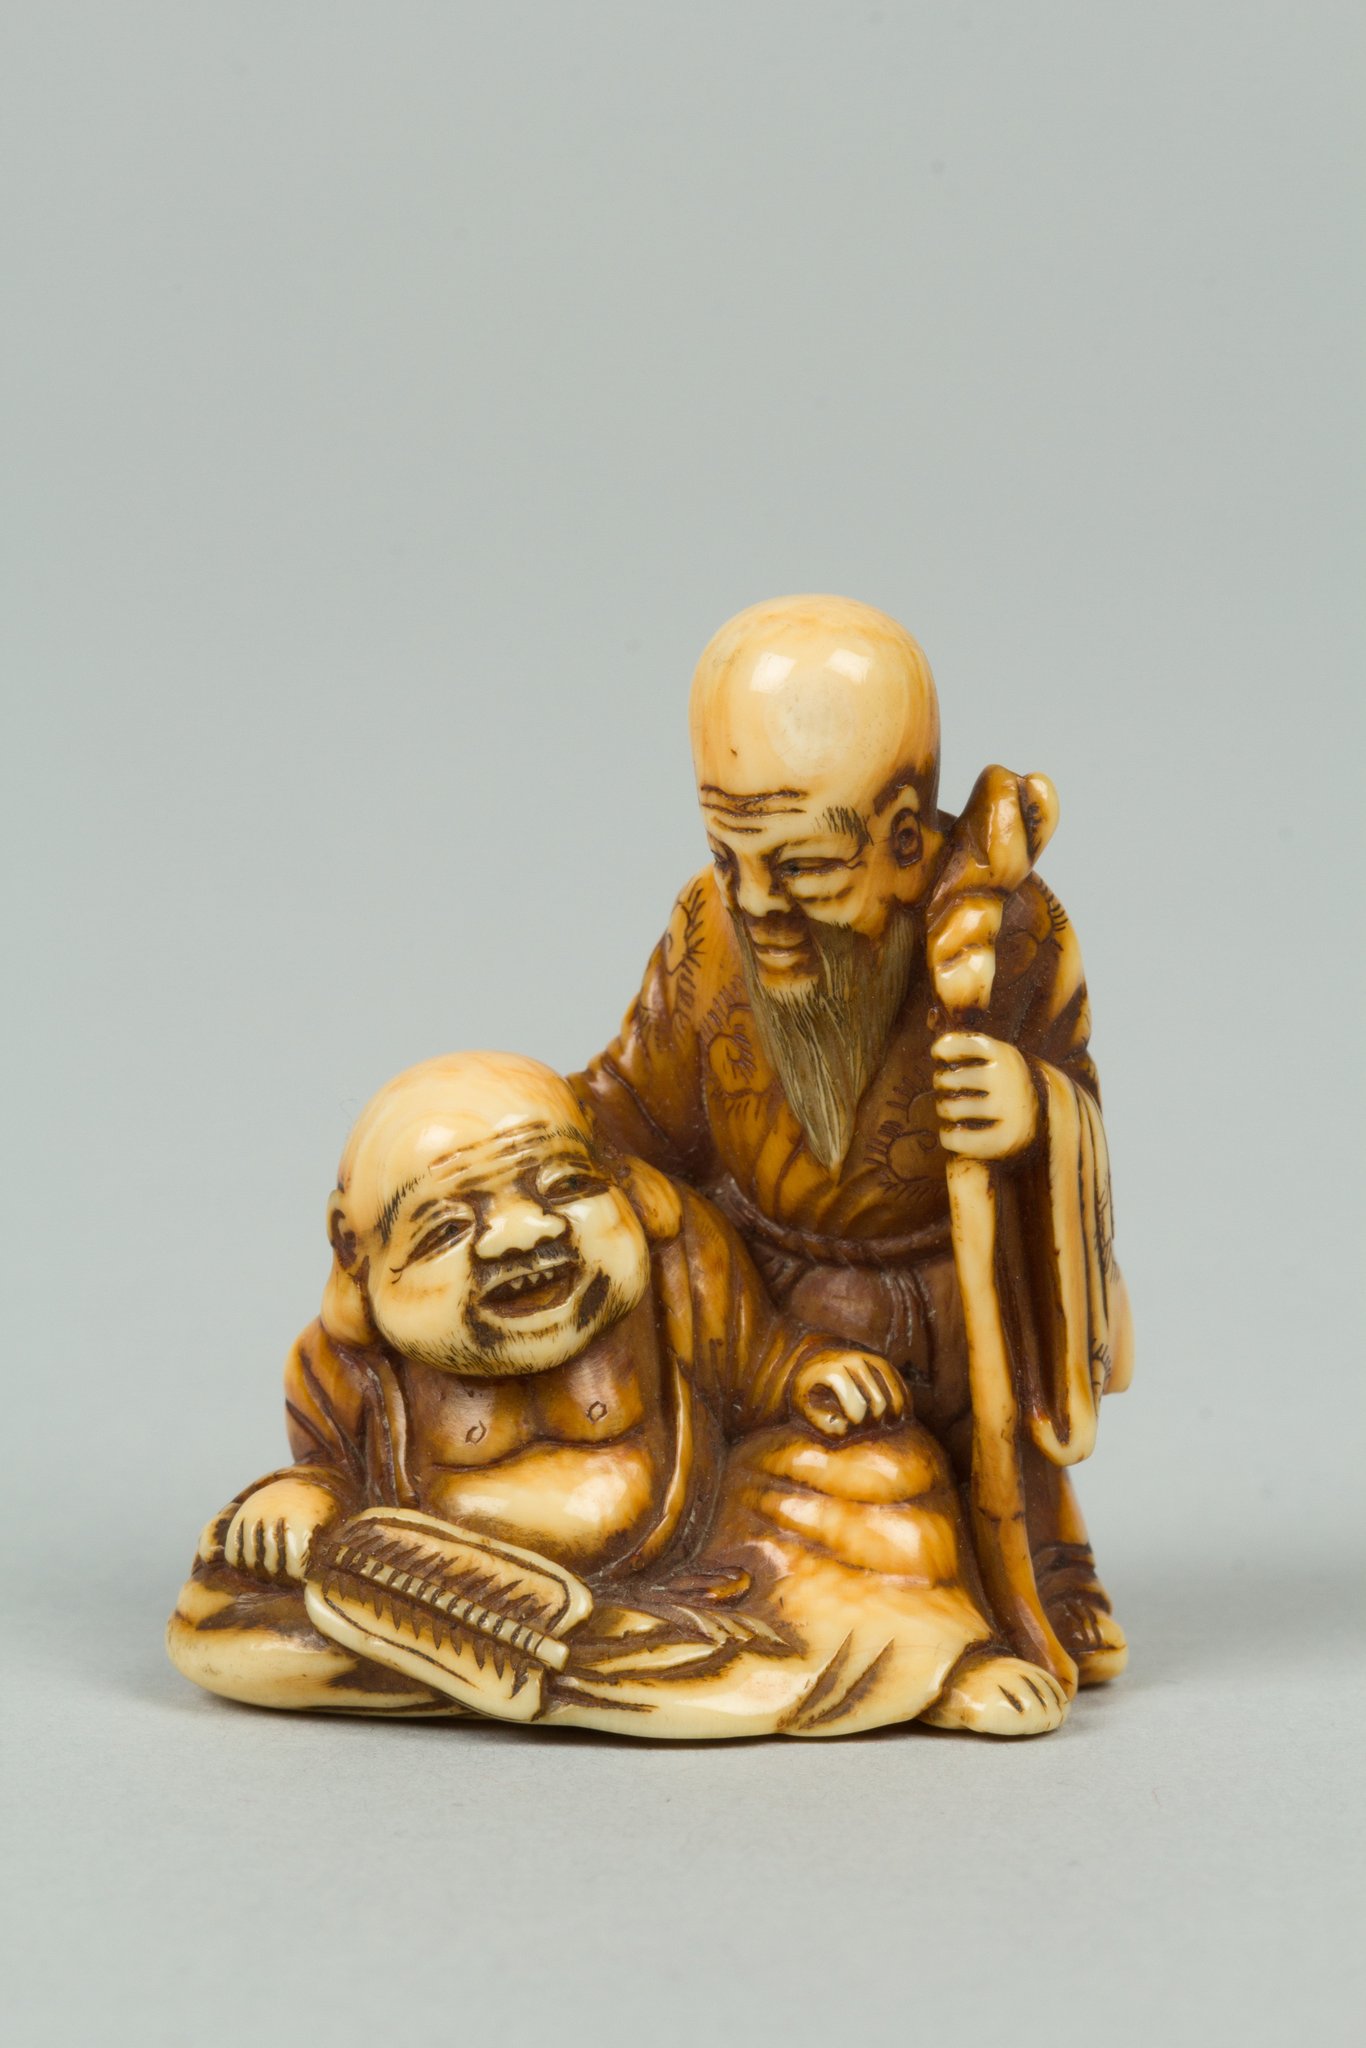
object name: netsuke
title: Netsuke of Hotai and Fukurokujin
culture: japanese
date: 1701-1800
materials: ivory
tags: men